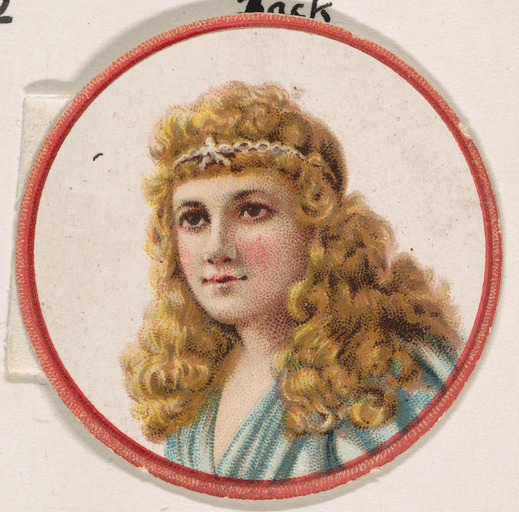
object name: print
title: Portrait of woman, from the Novelties series (N228, Type 2) issued by Kinney Bros.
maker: kinney brothers tobacco company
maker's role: publisher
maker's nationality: american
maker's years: 1869-2011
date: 1889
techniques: color lithograph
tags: portraits,women